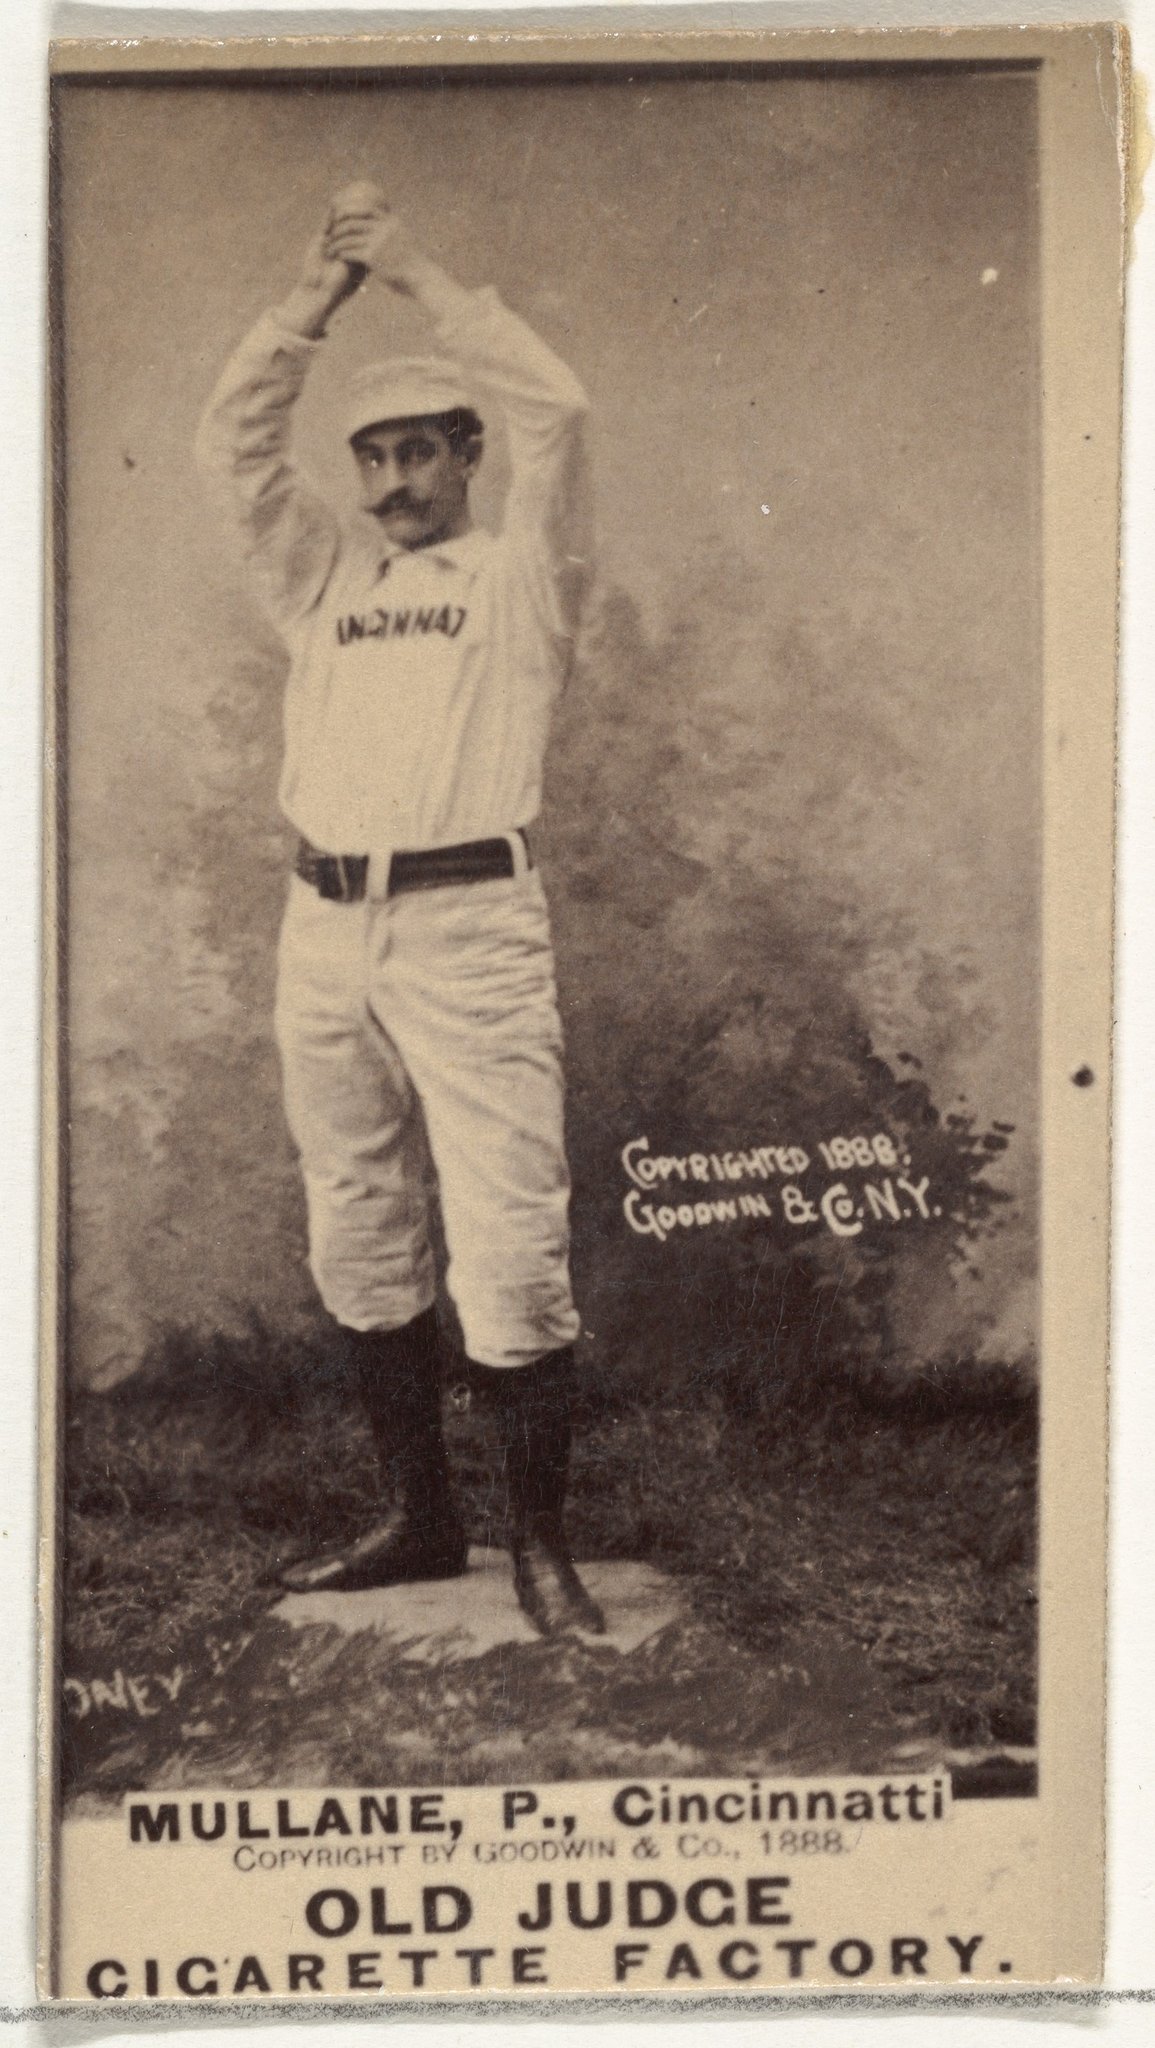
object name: baseball card, photograph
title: Anthony John "Tony" Mullane, Pitcher, Cincinnati, from the Old Judge series (N172) for Old Judge Cigarettes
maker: goodwin & company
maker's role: publisher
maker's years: 1850-1950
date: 1888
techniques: albumen silver print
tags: men,portraits,baseball,athletes